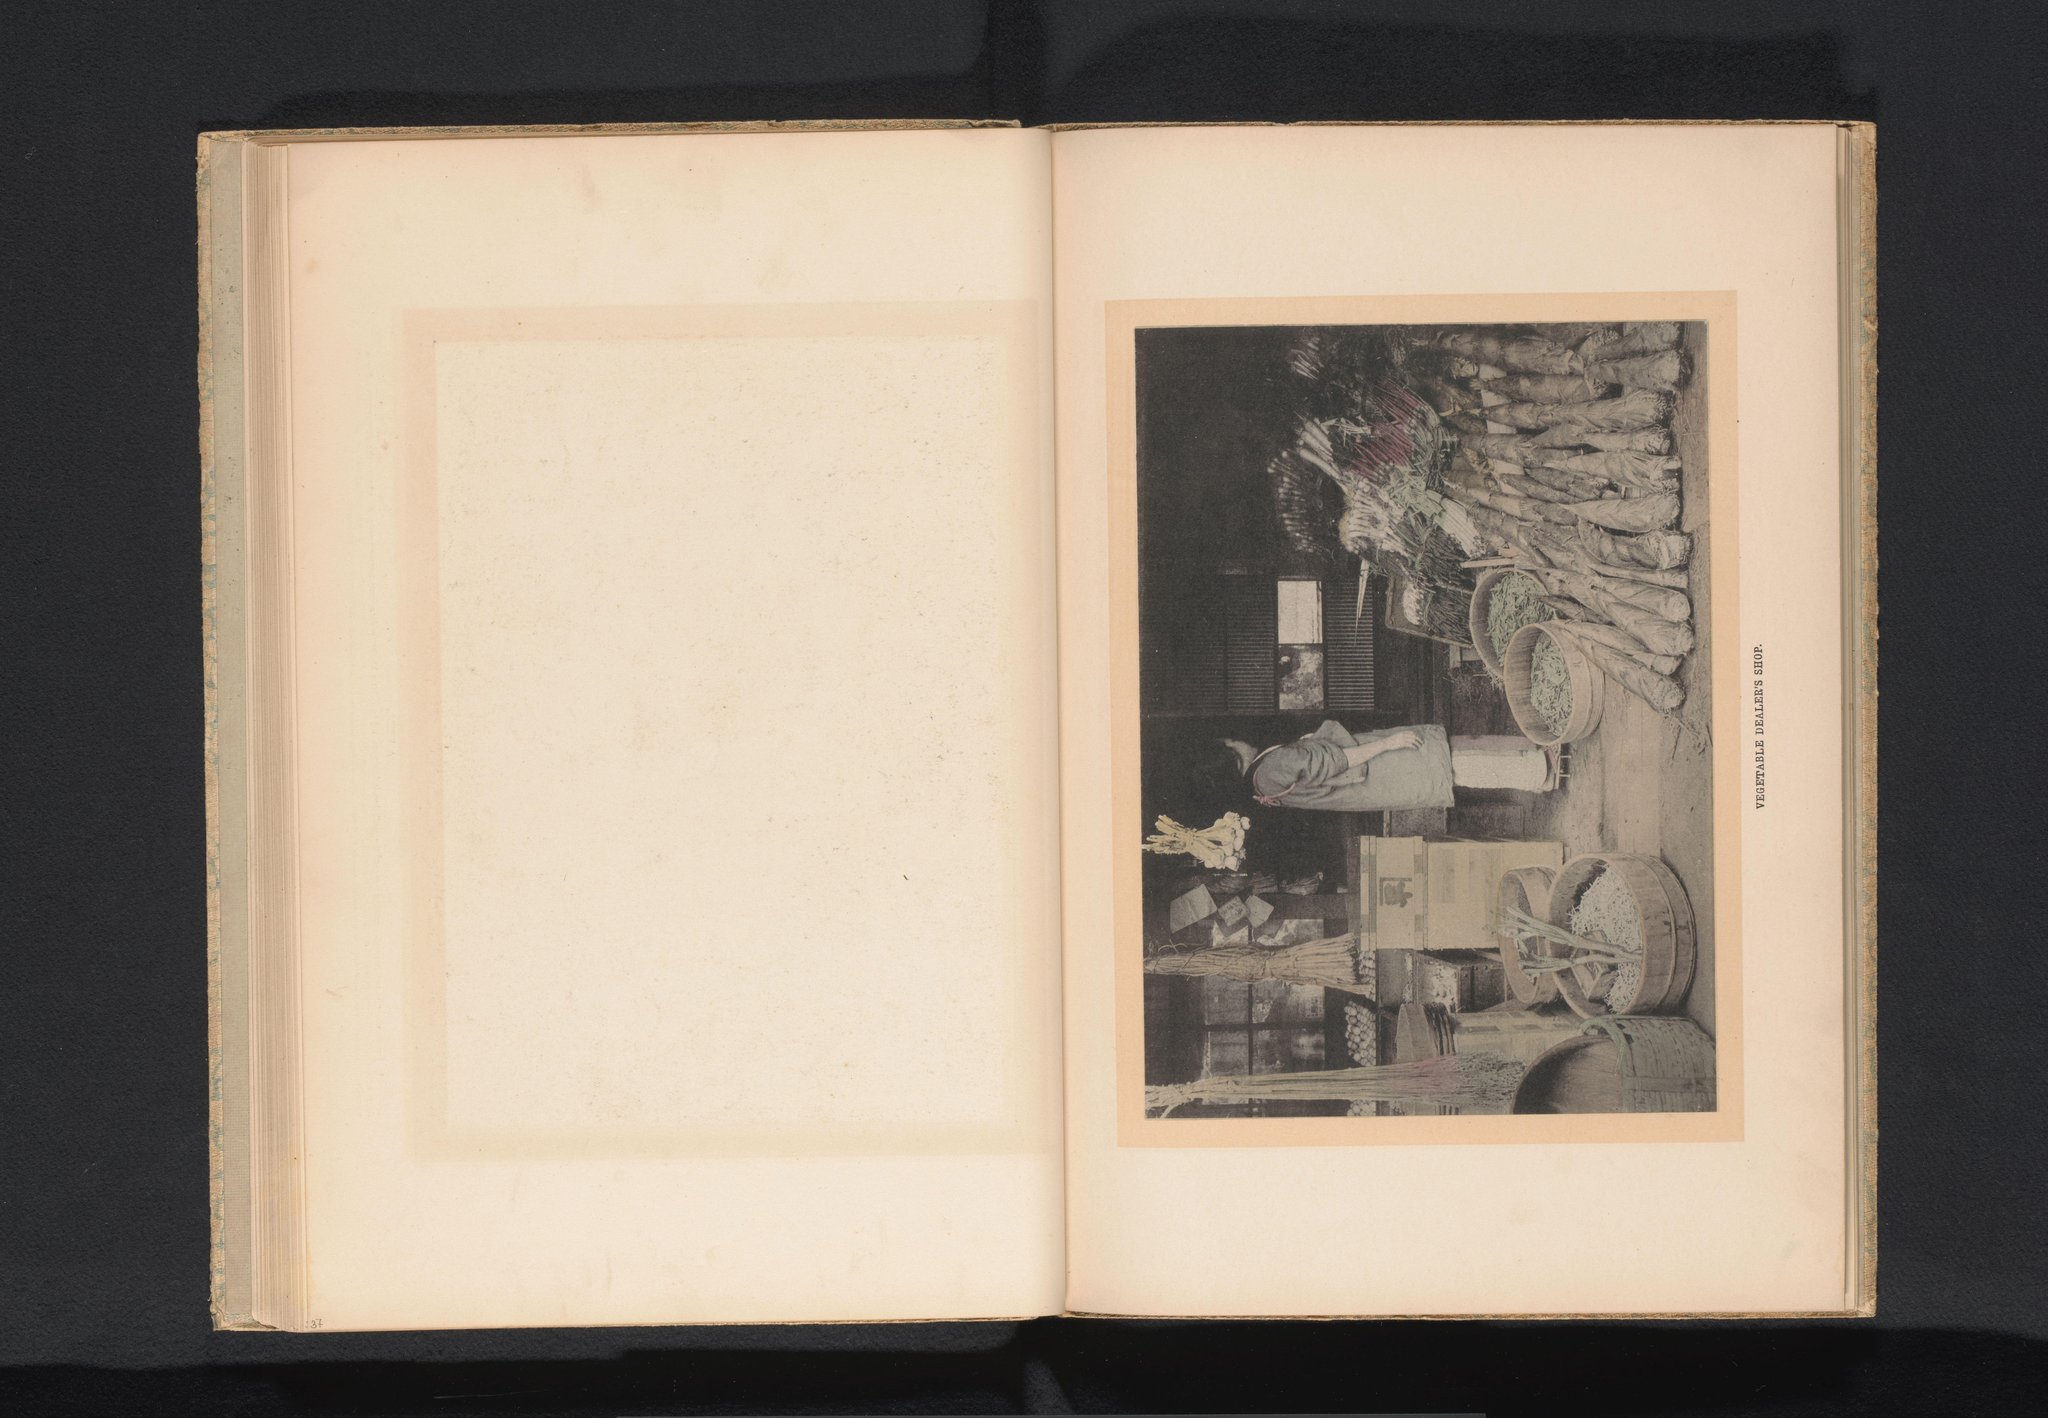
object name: page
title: Vegetable Dealer's Shop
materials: paper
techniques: photograph, lithograph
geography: tokyo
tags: merchant, salesman (with name of trade or profession) - bb - women engaged in trade and commerce, japan